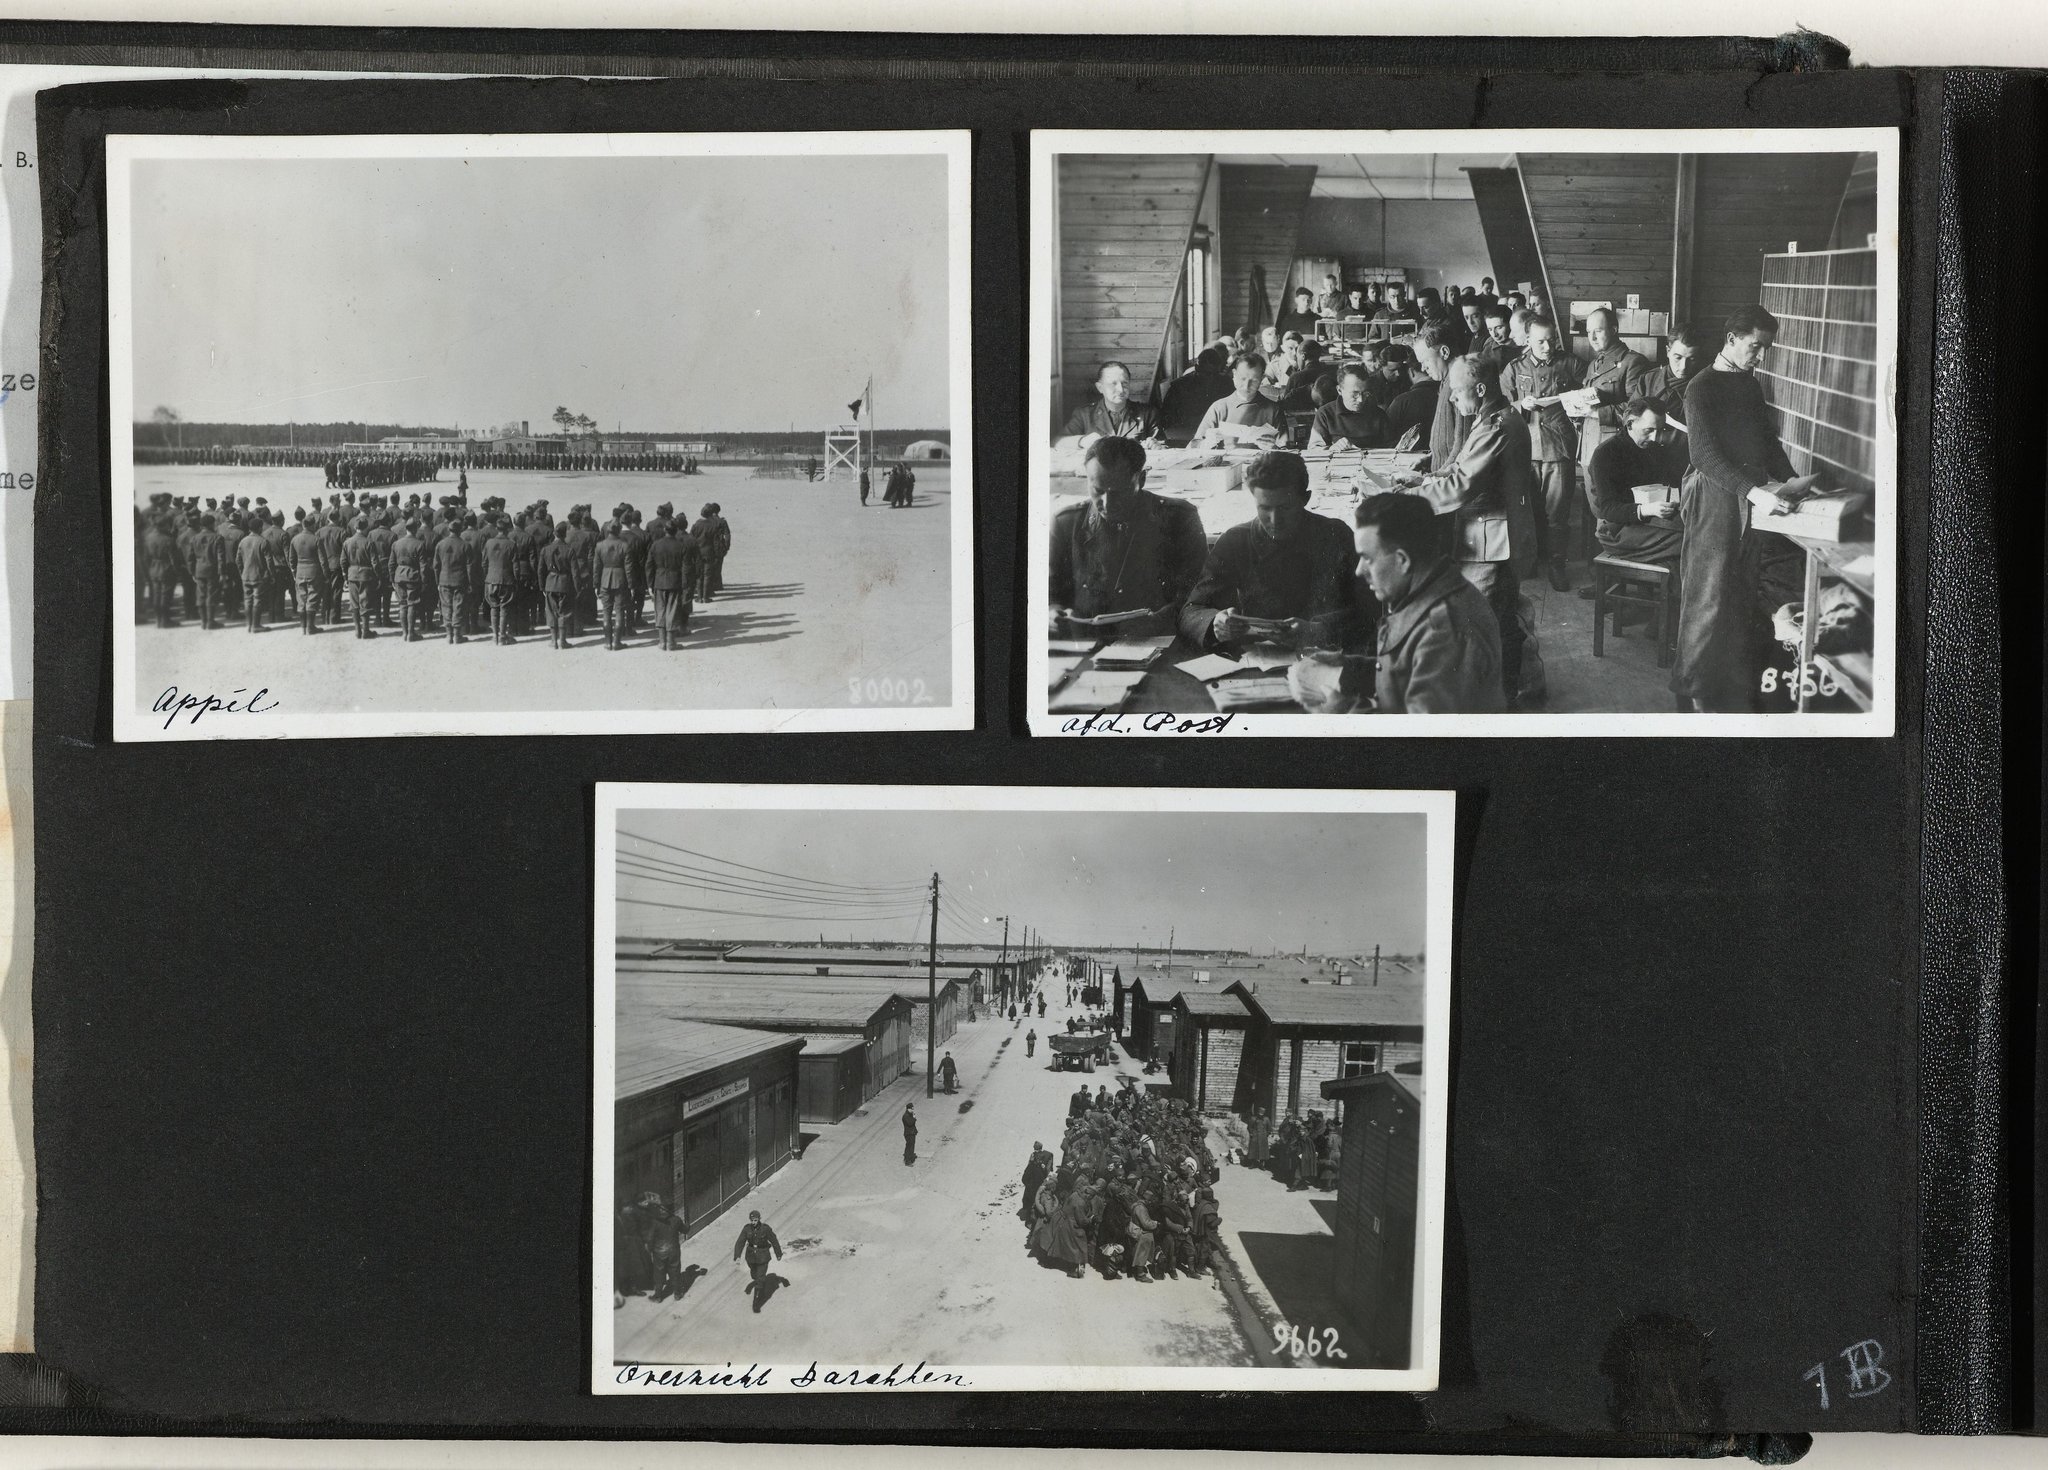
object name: album leaf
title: Appél / afd. Post / overzicht barakken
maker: dick w.b. van maarseveen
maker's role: fotograaf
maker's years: 1905-1990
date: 1943-1945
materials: cardboard, photographic support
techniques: gelatin silver print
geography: muhlberg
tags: the hague, dick w.b. van maarseveen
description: Albumblad met drie foto's: gevangenen op appel, de postafdeling en een overzicht van de barakken met een groep gevangen. Onderdeel van een fotoalbum met foto's door Dick van Maarseveen van het krijgsgevangenenkamp Stalag IV B in Mühlberg in de periode 1943-1945.